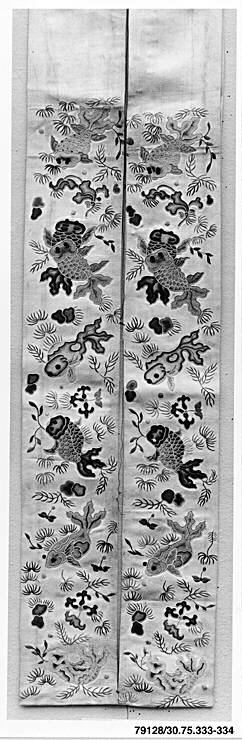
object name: sleeve band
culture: chinese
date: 1801-1900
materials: silk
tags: fish